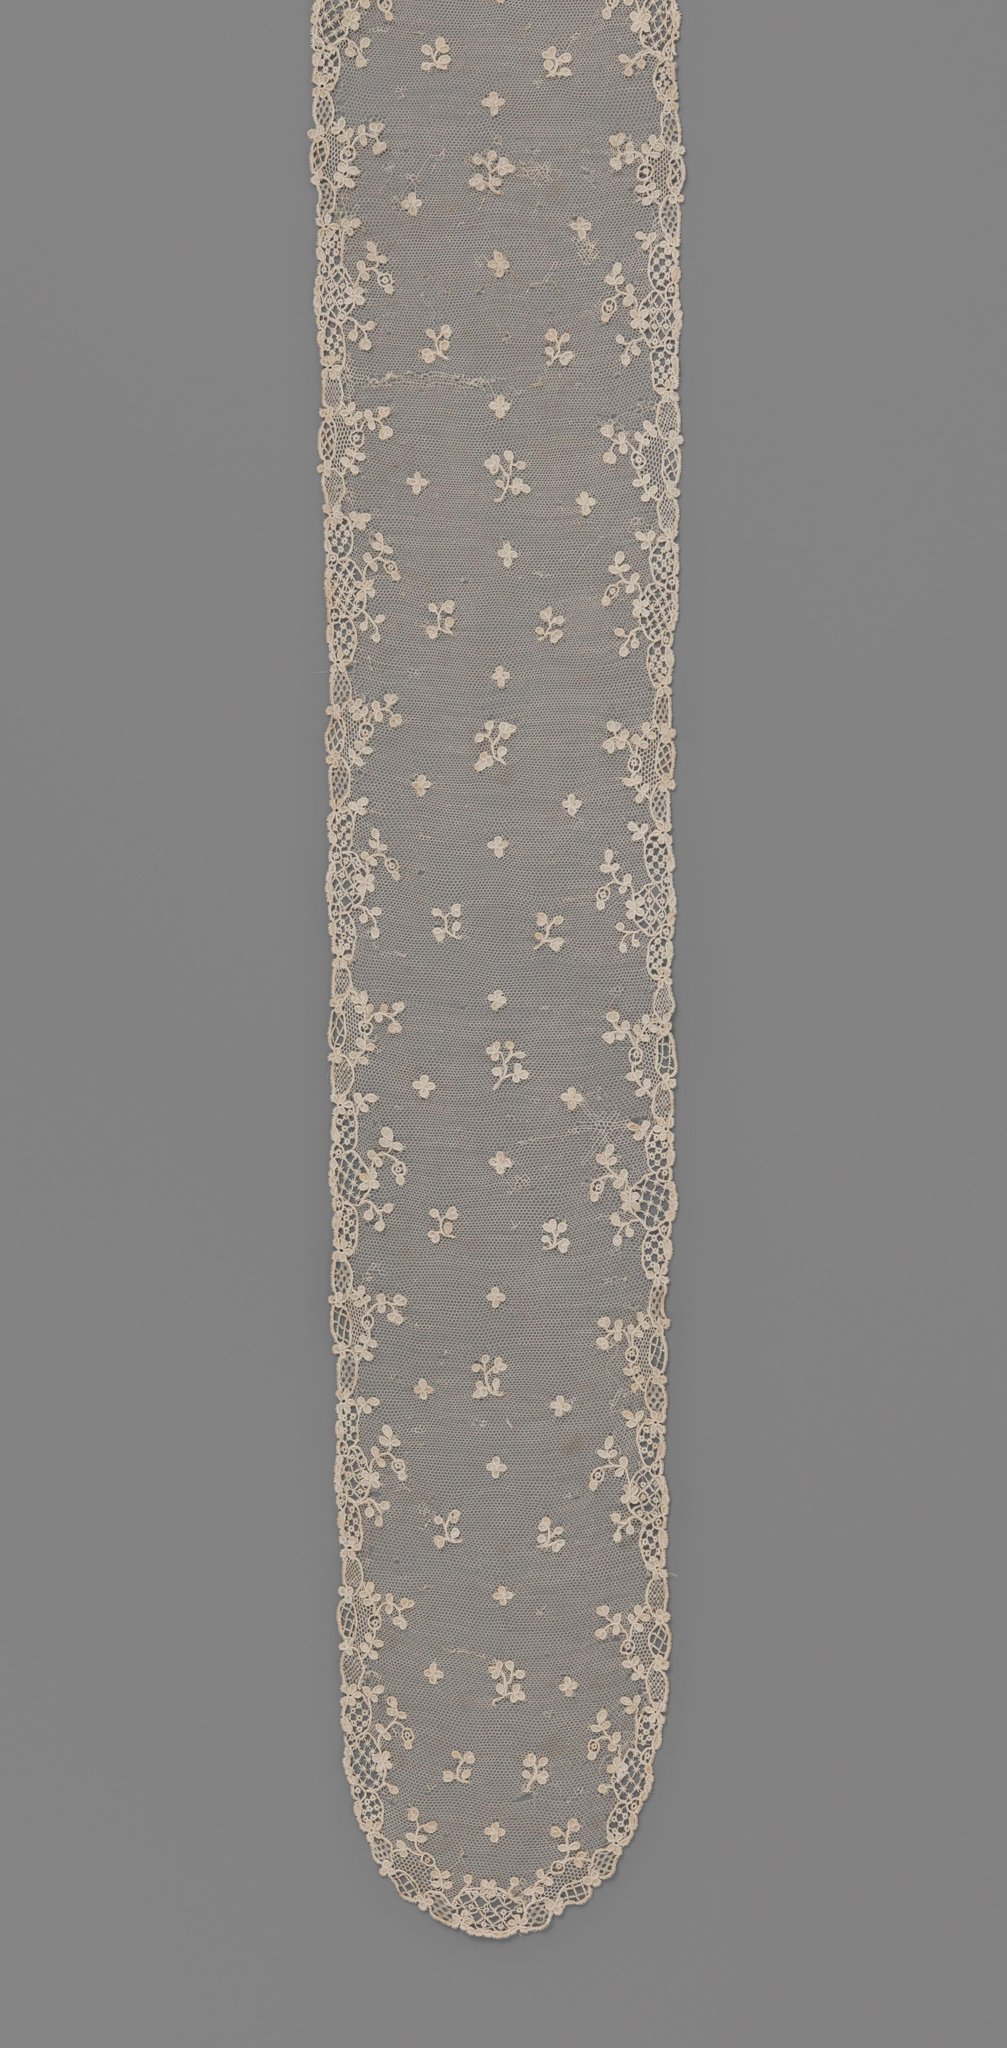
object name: lappet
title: Mutsenslip van naaldkant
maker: Anonymous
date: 1780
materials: lace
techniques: lace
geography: western europe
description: Een mutsenslip van naaldkant op een grond van fijne mazen zijn strooitakjes met gefestonneerde contouren gewerkt. Langs de randen en ronde punt zijn rozetvormige bloempjes en diverse siersteken genaaid, die afgezet zijn met picots.